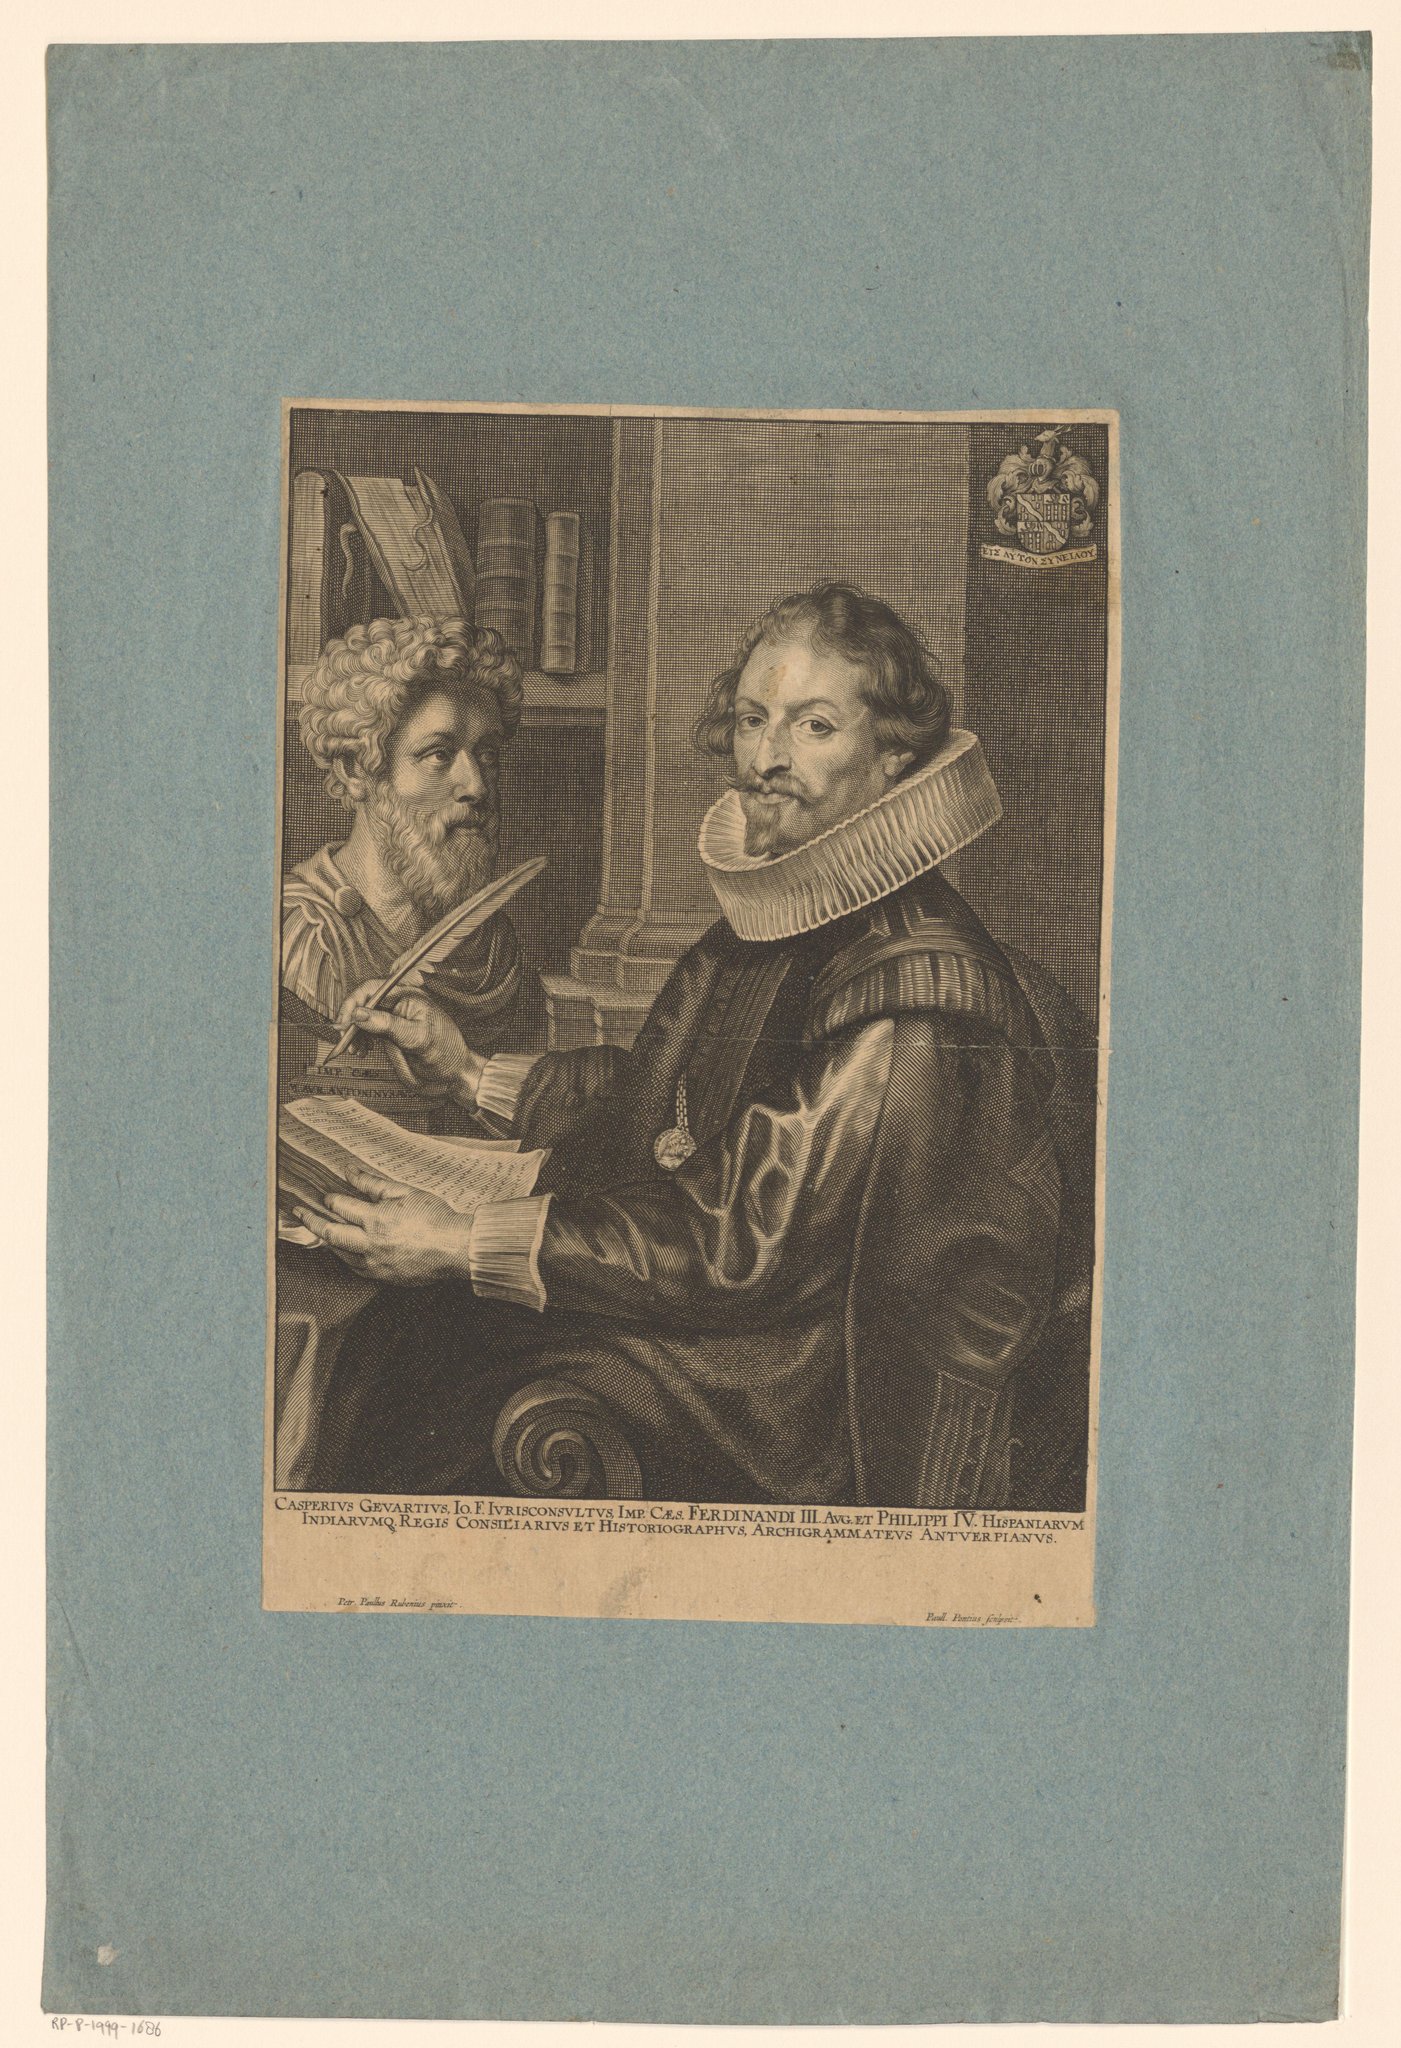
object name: print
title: Portret van Jean Gaspard Gevartius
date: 1613-1658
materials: paper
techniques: engraving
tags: politician, jean gaspard gevartius, historical persons, armorial bearing, heraldry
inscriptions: collector's mark: Lugt 2228, collector's mark: Lugt 2760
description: Op zijn werktafel een buste van Marcus Antonius. Rechtsboven zijn wapenschild.